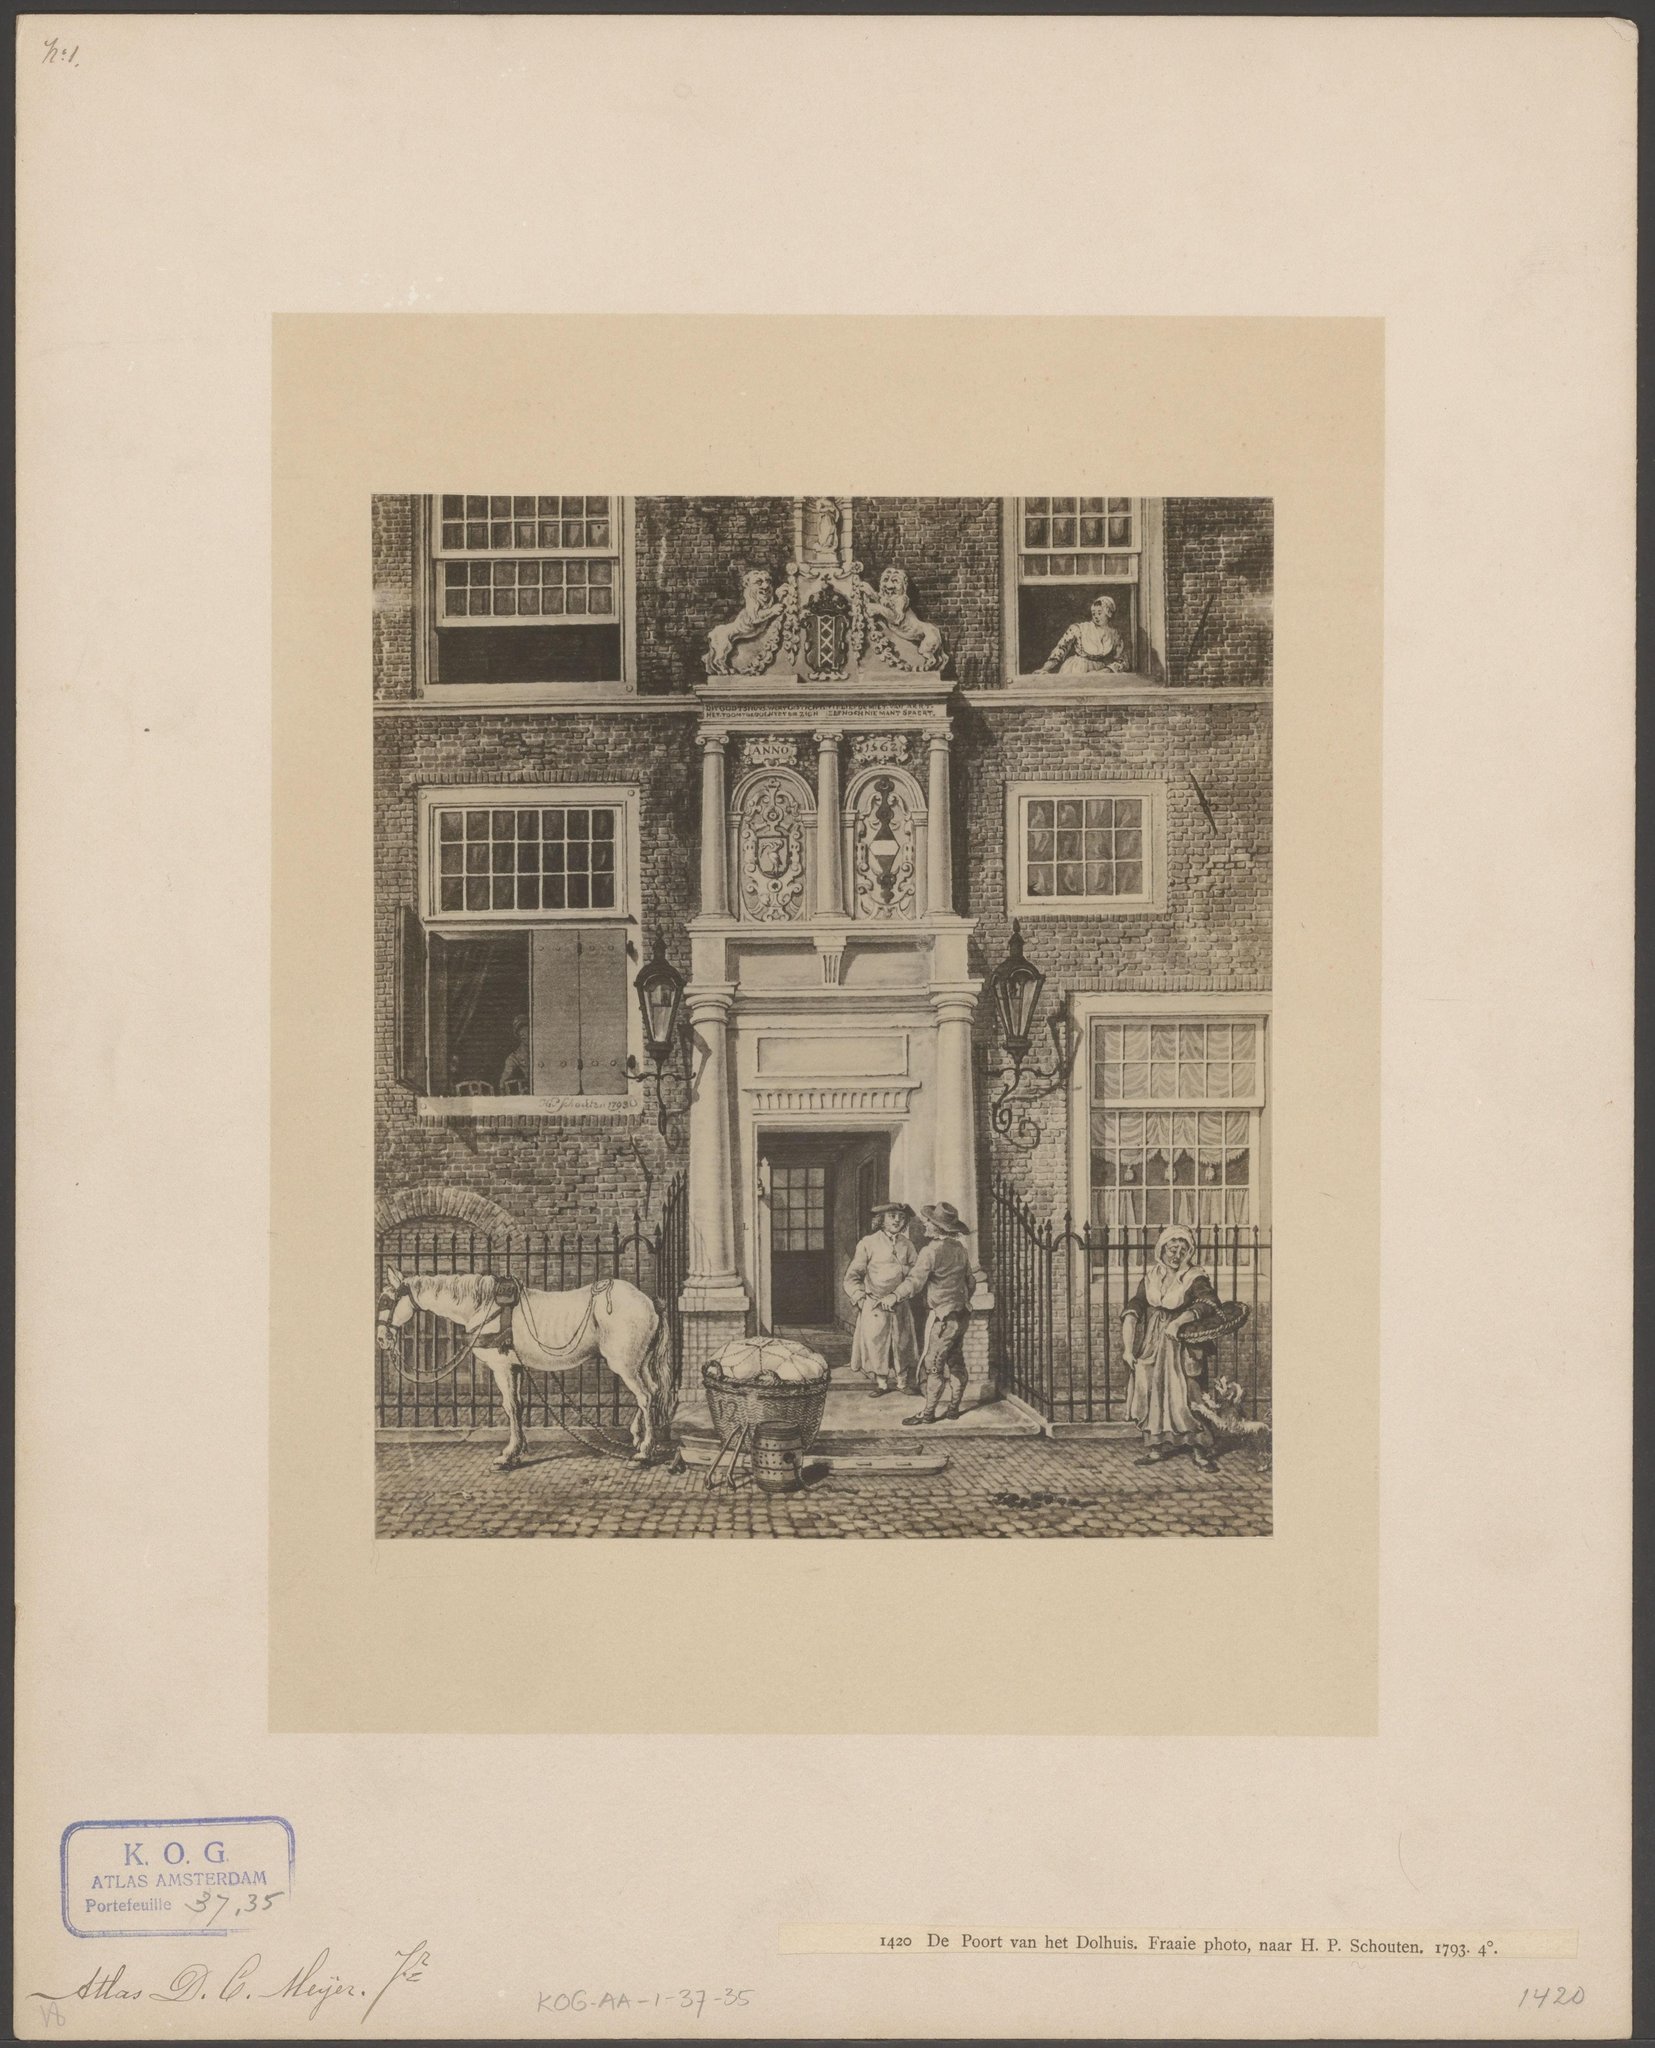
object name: photograph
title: Fotoreproductie van een tekening van de poort van het Dolhuis te Amsterdam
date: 1900-1908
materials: paper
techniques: gelatin silver print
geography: netherlands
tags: gate, entrance, lunatic asylum, mental home, street (+ city(-scape) with figures, staffage), dolhuis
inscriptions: collector's mark: Lugt 1641b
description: Onderwerpsrubriek binnen de Atlas Amsterdam: Armwezen en liefdadige instellingen: I. Stadsinrichtingen: Dolhuis.